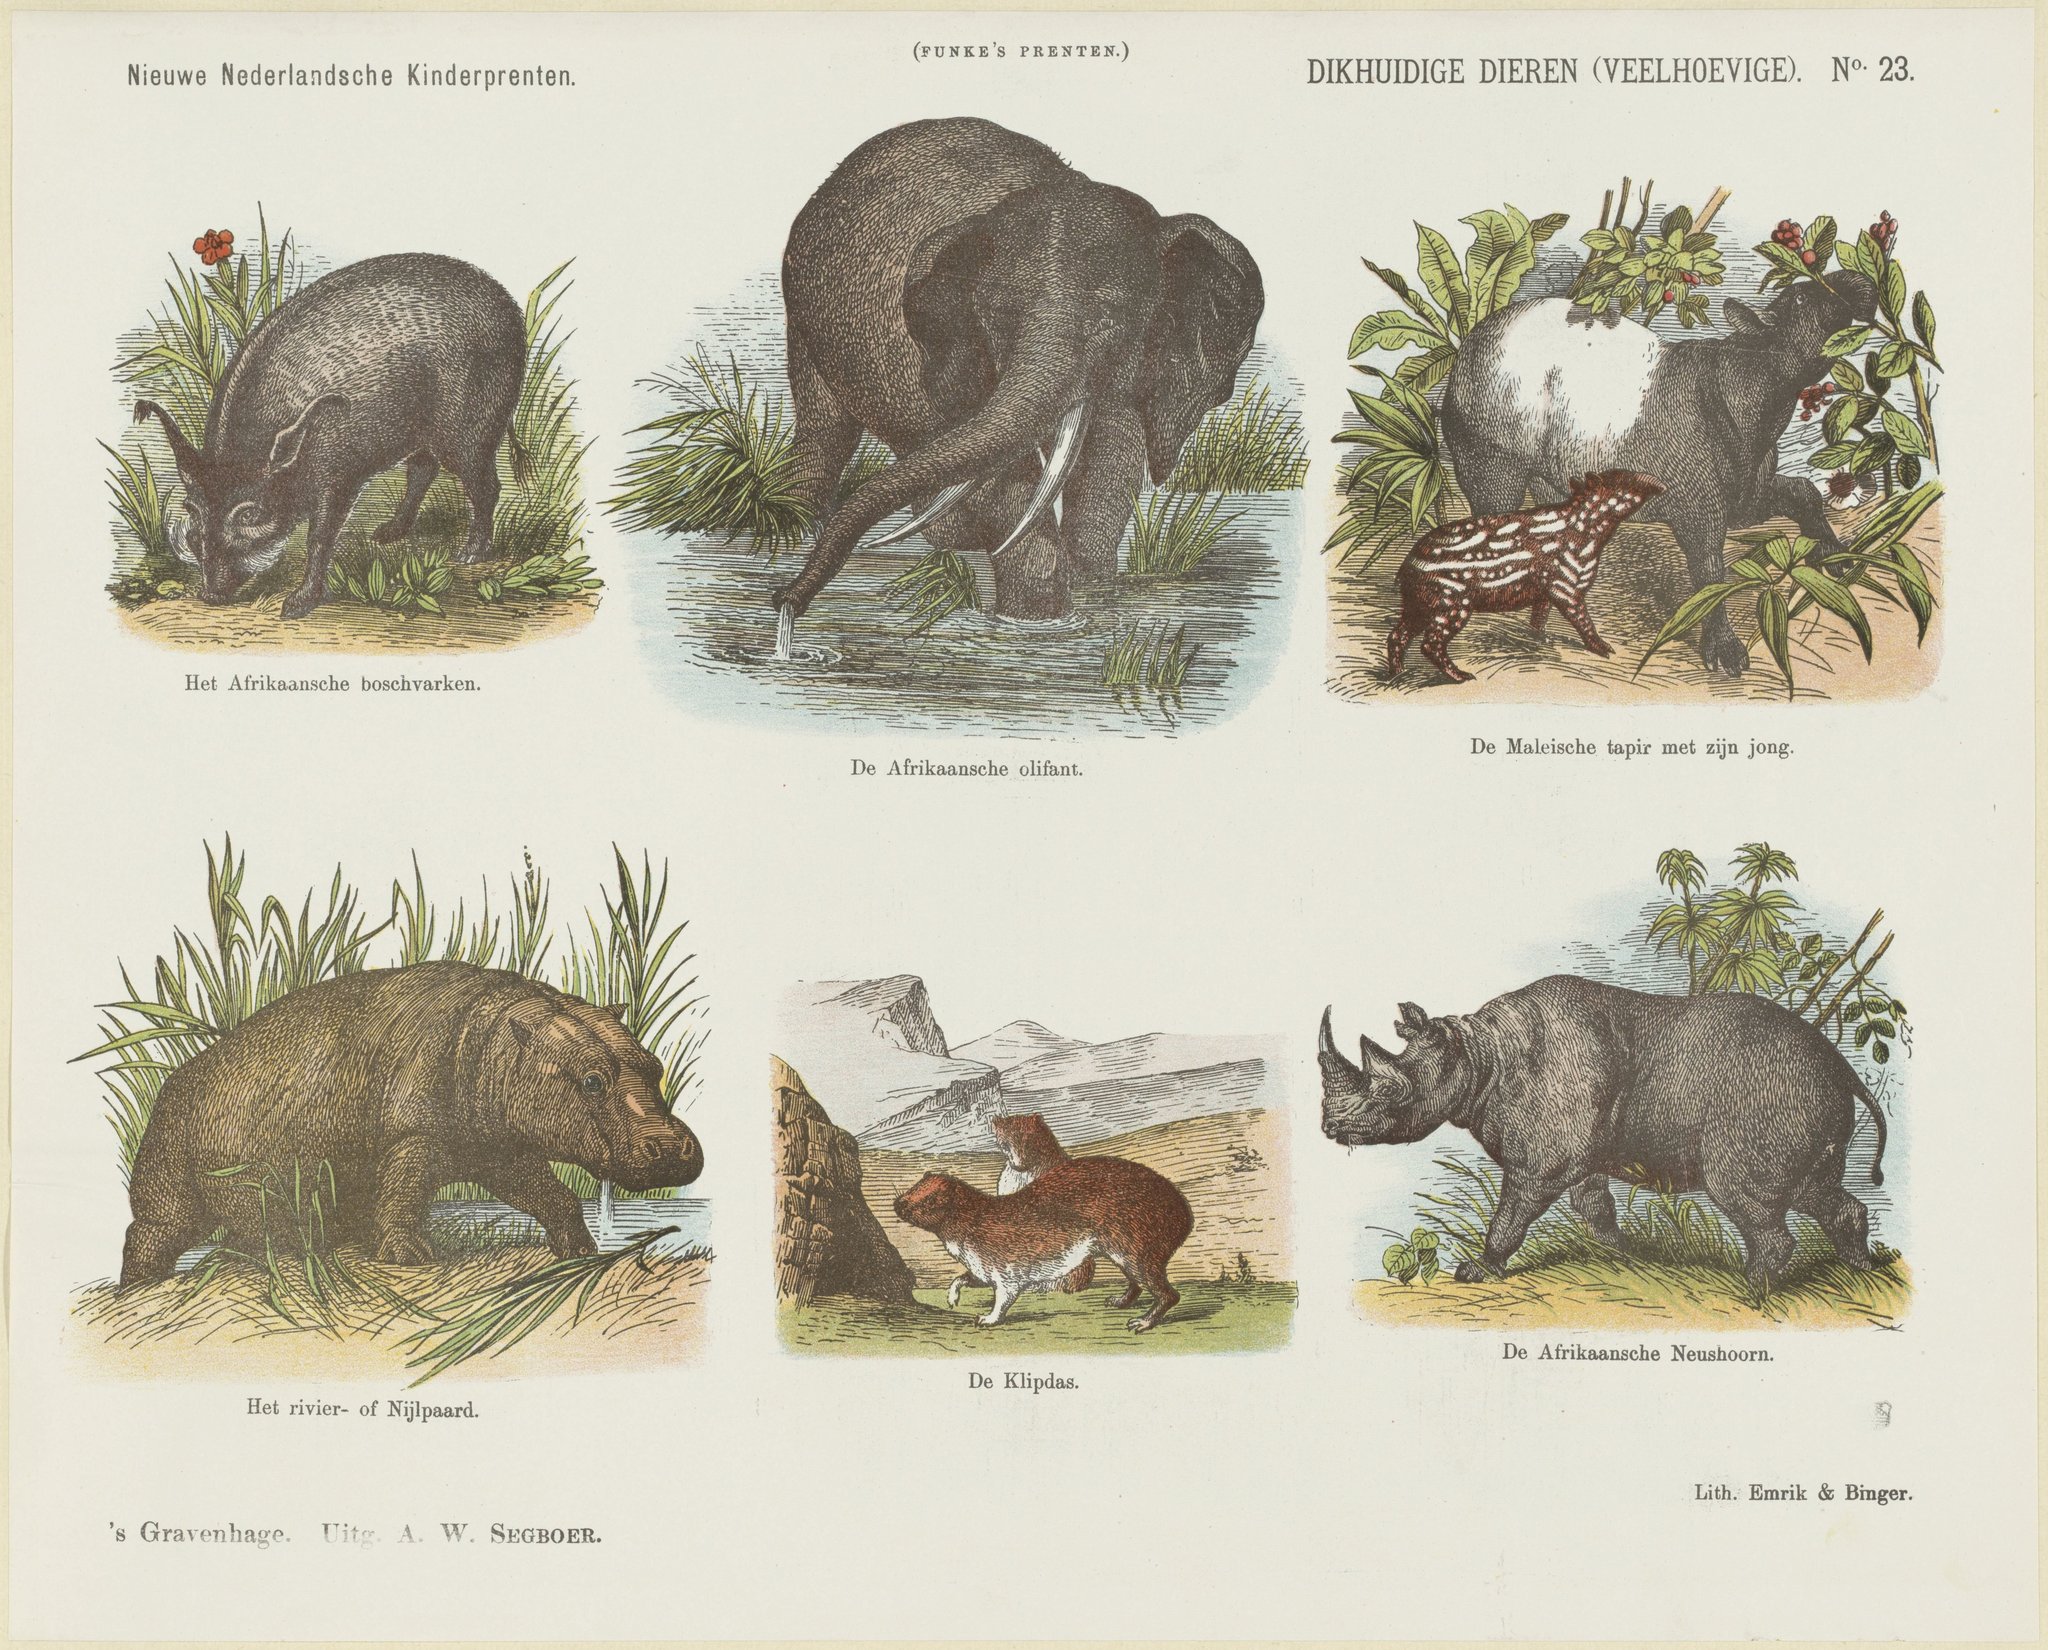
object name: popular print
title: Funke's prenten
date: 1903-1919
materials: paper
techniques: lithograph, letterpress printing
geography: haarlem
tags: hoofed animals: hippopotamus, animals, hoofed animals: rhinoceros, trunked animals: elephant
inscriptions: collector's mark: Lugt 2760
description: Blad met 6 voorstellingen van dieren, onder andere een olifant, een tapir, een nijlpaard en een neushoorn. Onder elke afbeelding een onderschrift. Genummerd rechtsboven: No. 23.